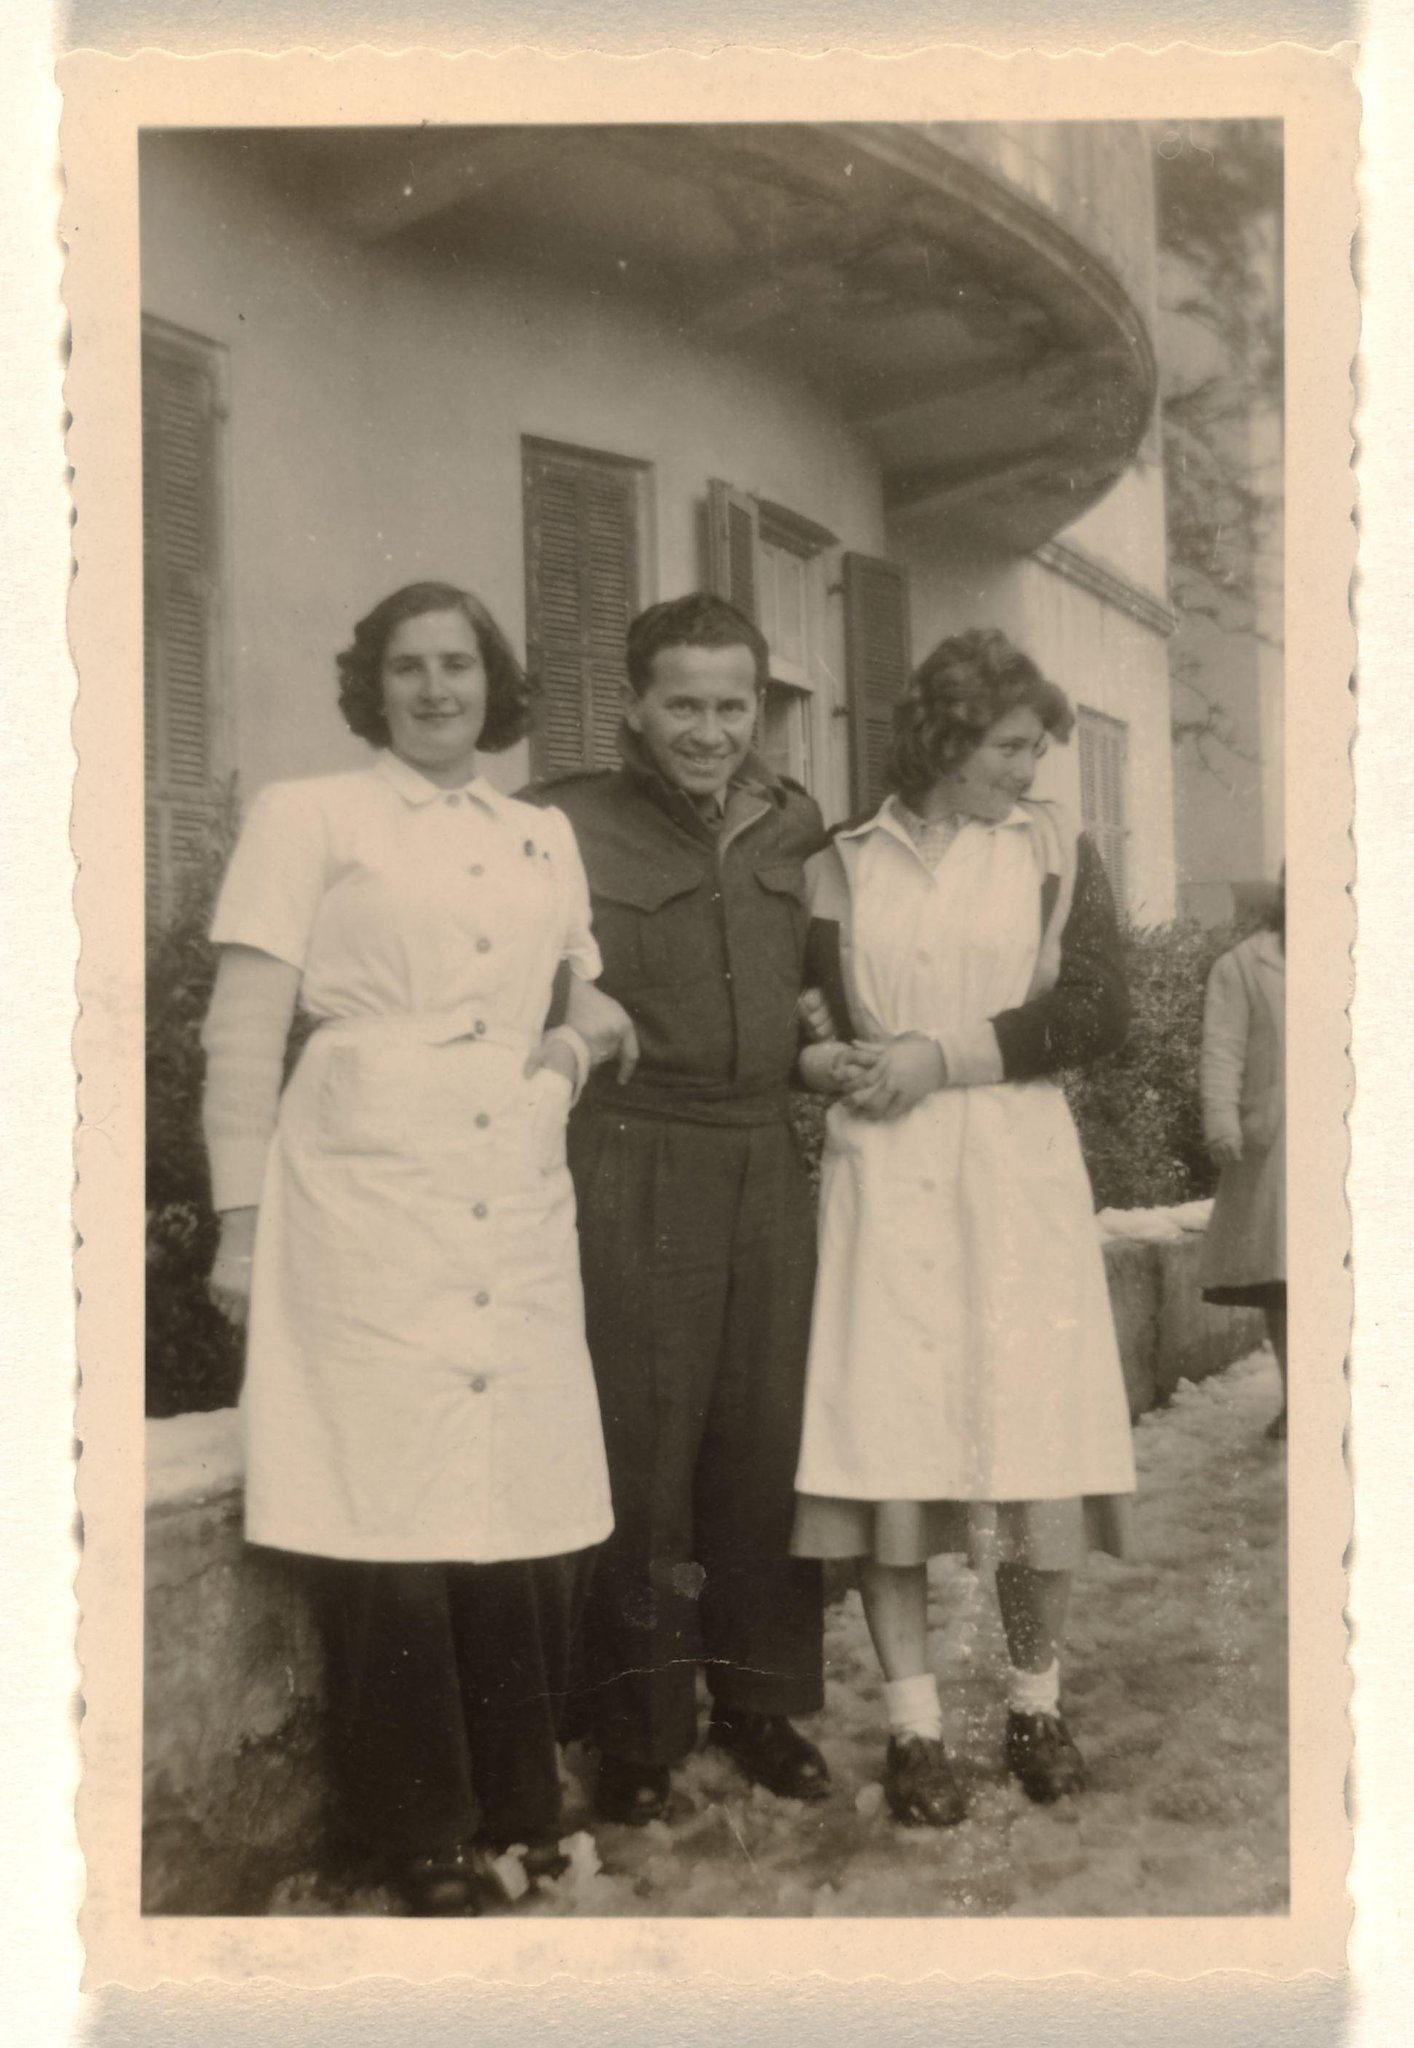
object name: photograph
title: Isabel Wachenheimer met twee onbekende personen voor het sanatorium Etania, 1945-1947, Davos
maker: Anonymous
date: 1945-1947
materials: photographic support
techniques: gelatin silver print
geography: davos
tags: leiden, isabel wachenheimer-elon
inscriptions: number: ‘23’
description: Isabel Wachenheimer (links), onbekende man in uniform (midden) en onbekende vrouw (rechts)